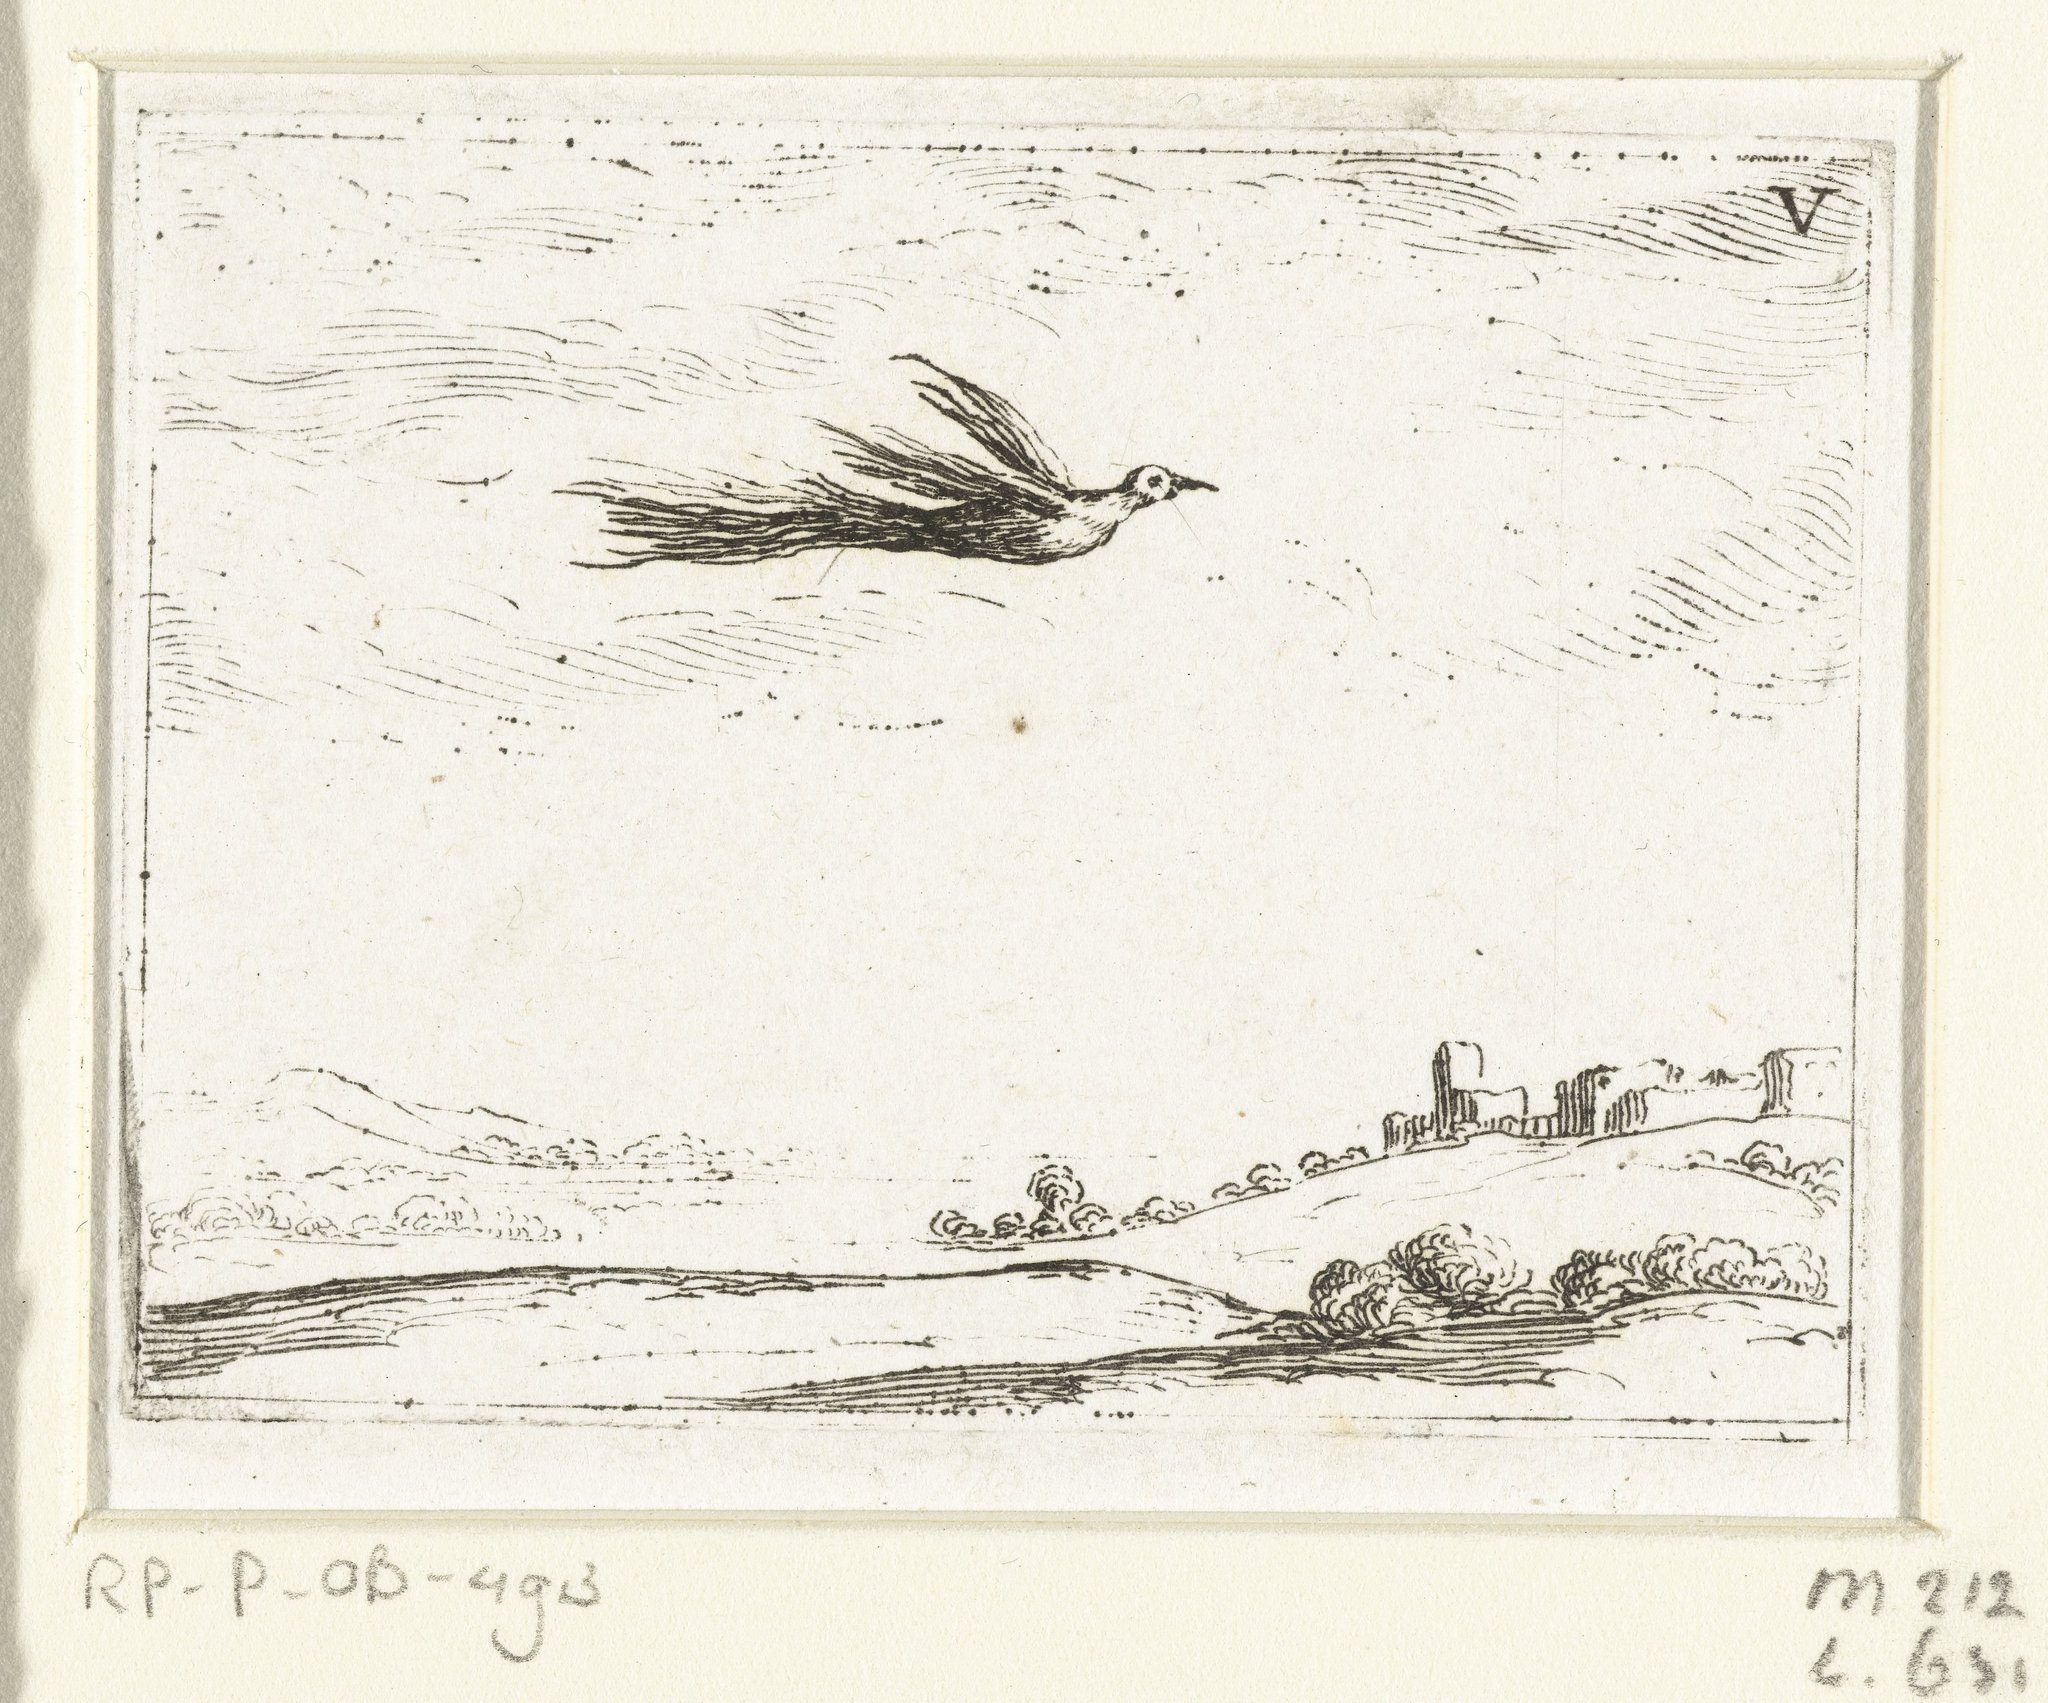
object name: print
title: Paradijsvogel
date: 1625-1629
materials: paper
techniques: etching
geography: nancy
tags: ornamental birds: bird of paradise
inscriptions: collector's mark: Lugt 240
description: Voorstelling van een paradijsvogel die boven een landschap vliegt. Dit blad is onderdeel van de embleemserie 'Leven van Maria in emblemen'. De eerste staat van deze serie behelst naast een titelpagina en 26 emblemen ook drie bladen met lofzangen op Maria in boekdruk zonder afbeelding.